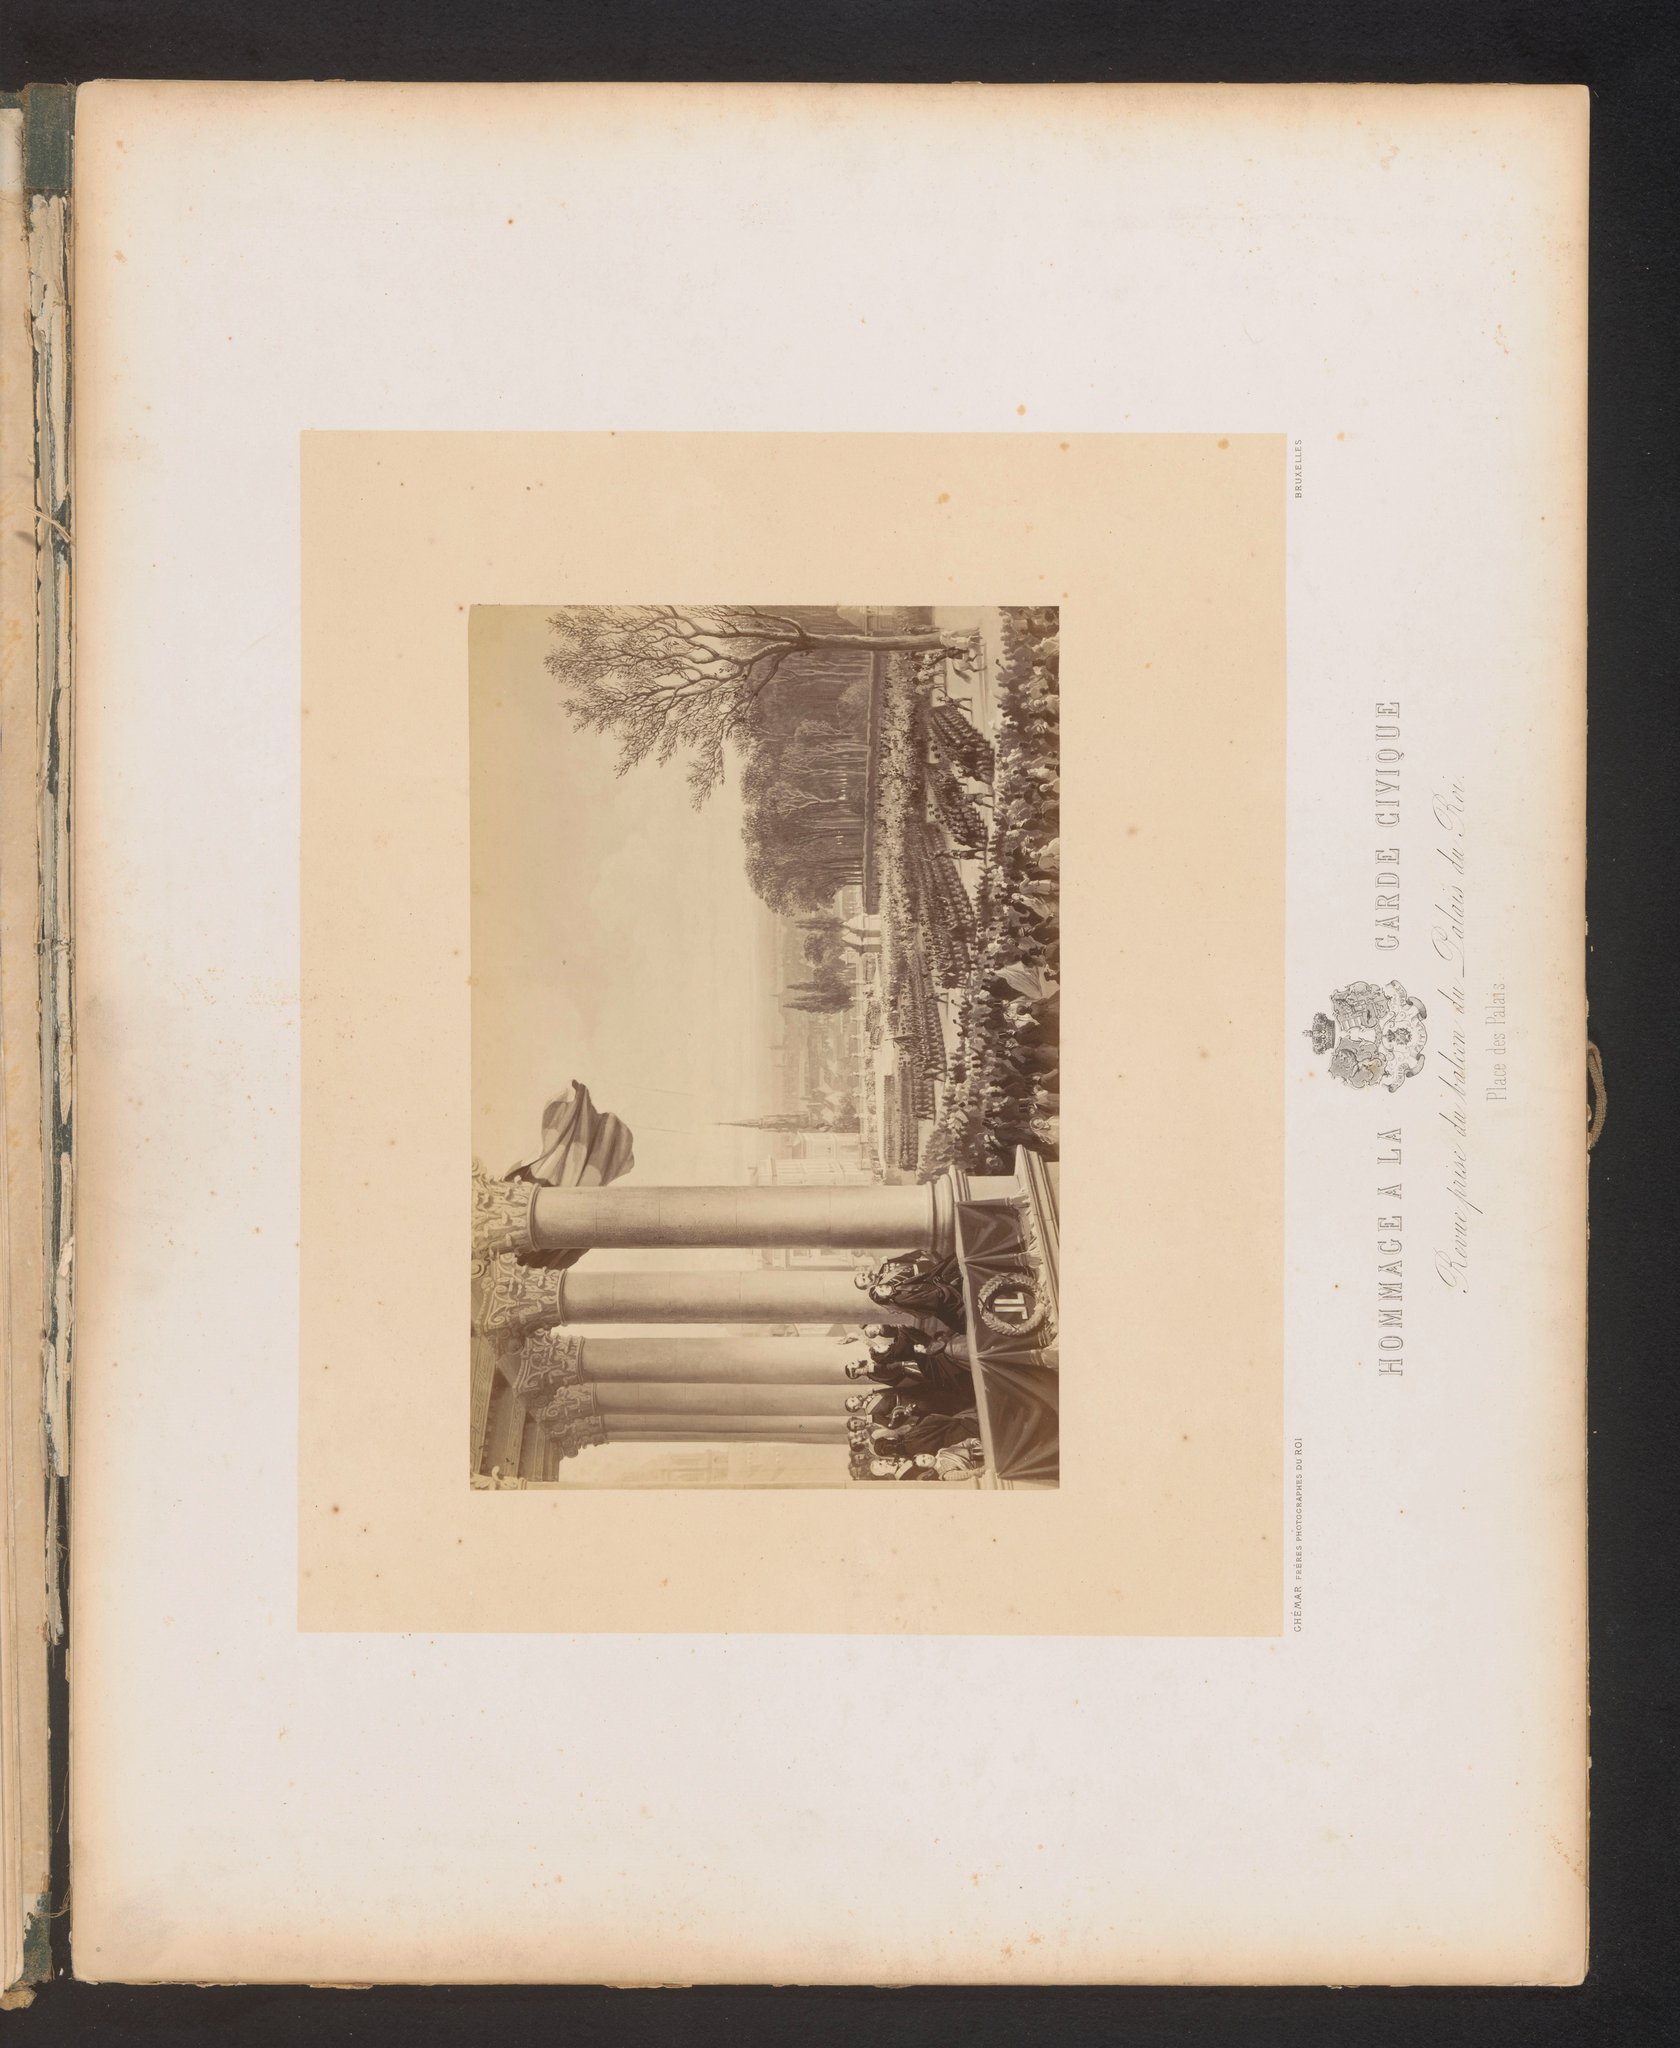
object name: photograph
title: Fotoreproductie van een ontwerp van een eerbetoon aan de schutterij tijdens de inhuldiging van Léopold II van België in Brussel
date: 1861-1866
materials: photographic support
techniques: albumen print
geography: brussels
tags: brussels, laeken, leopold ii (koning der belgen), king, guard duty, keeping sentry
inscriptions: inscription: ‘Place des Palais.’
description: Deze foto maakt deel uit van een omslag met veertien foto's.